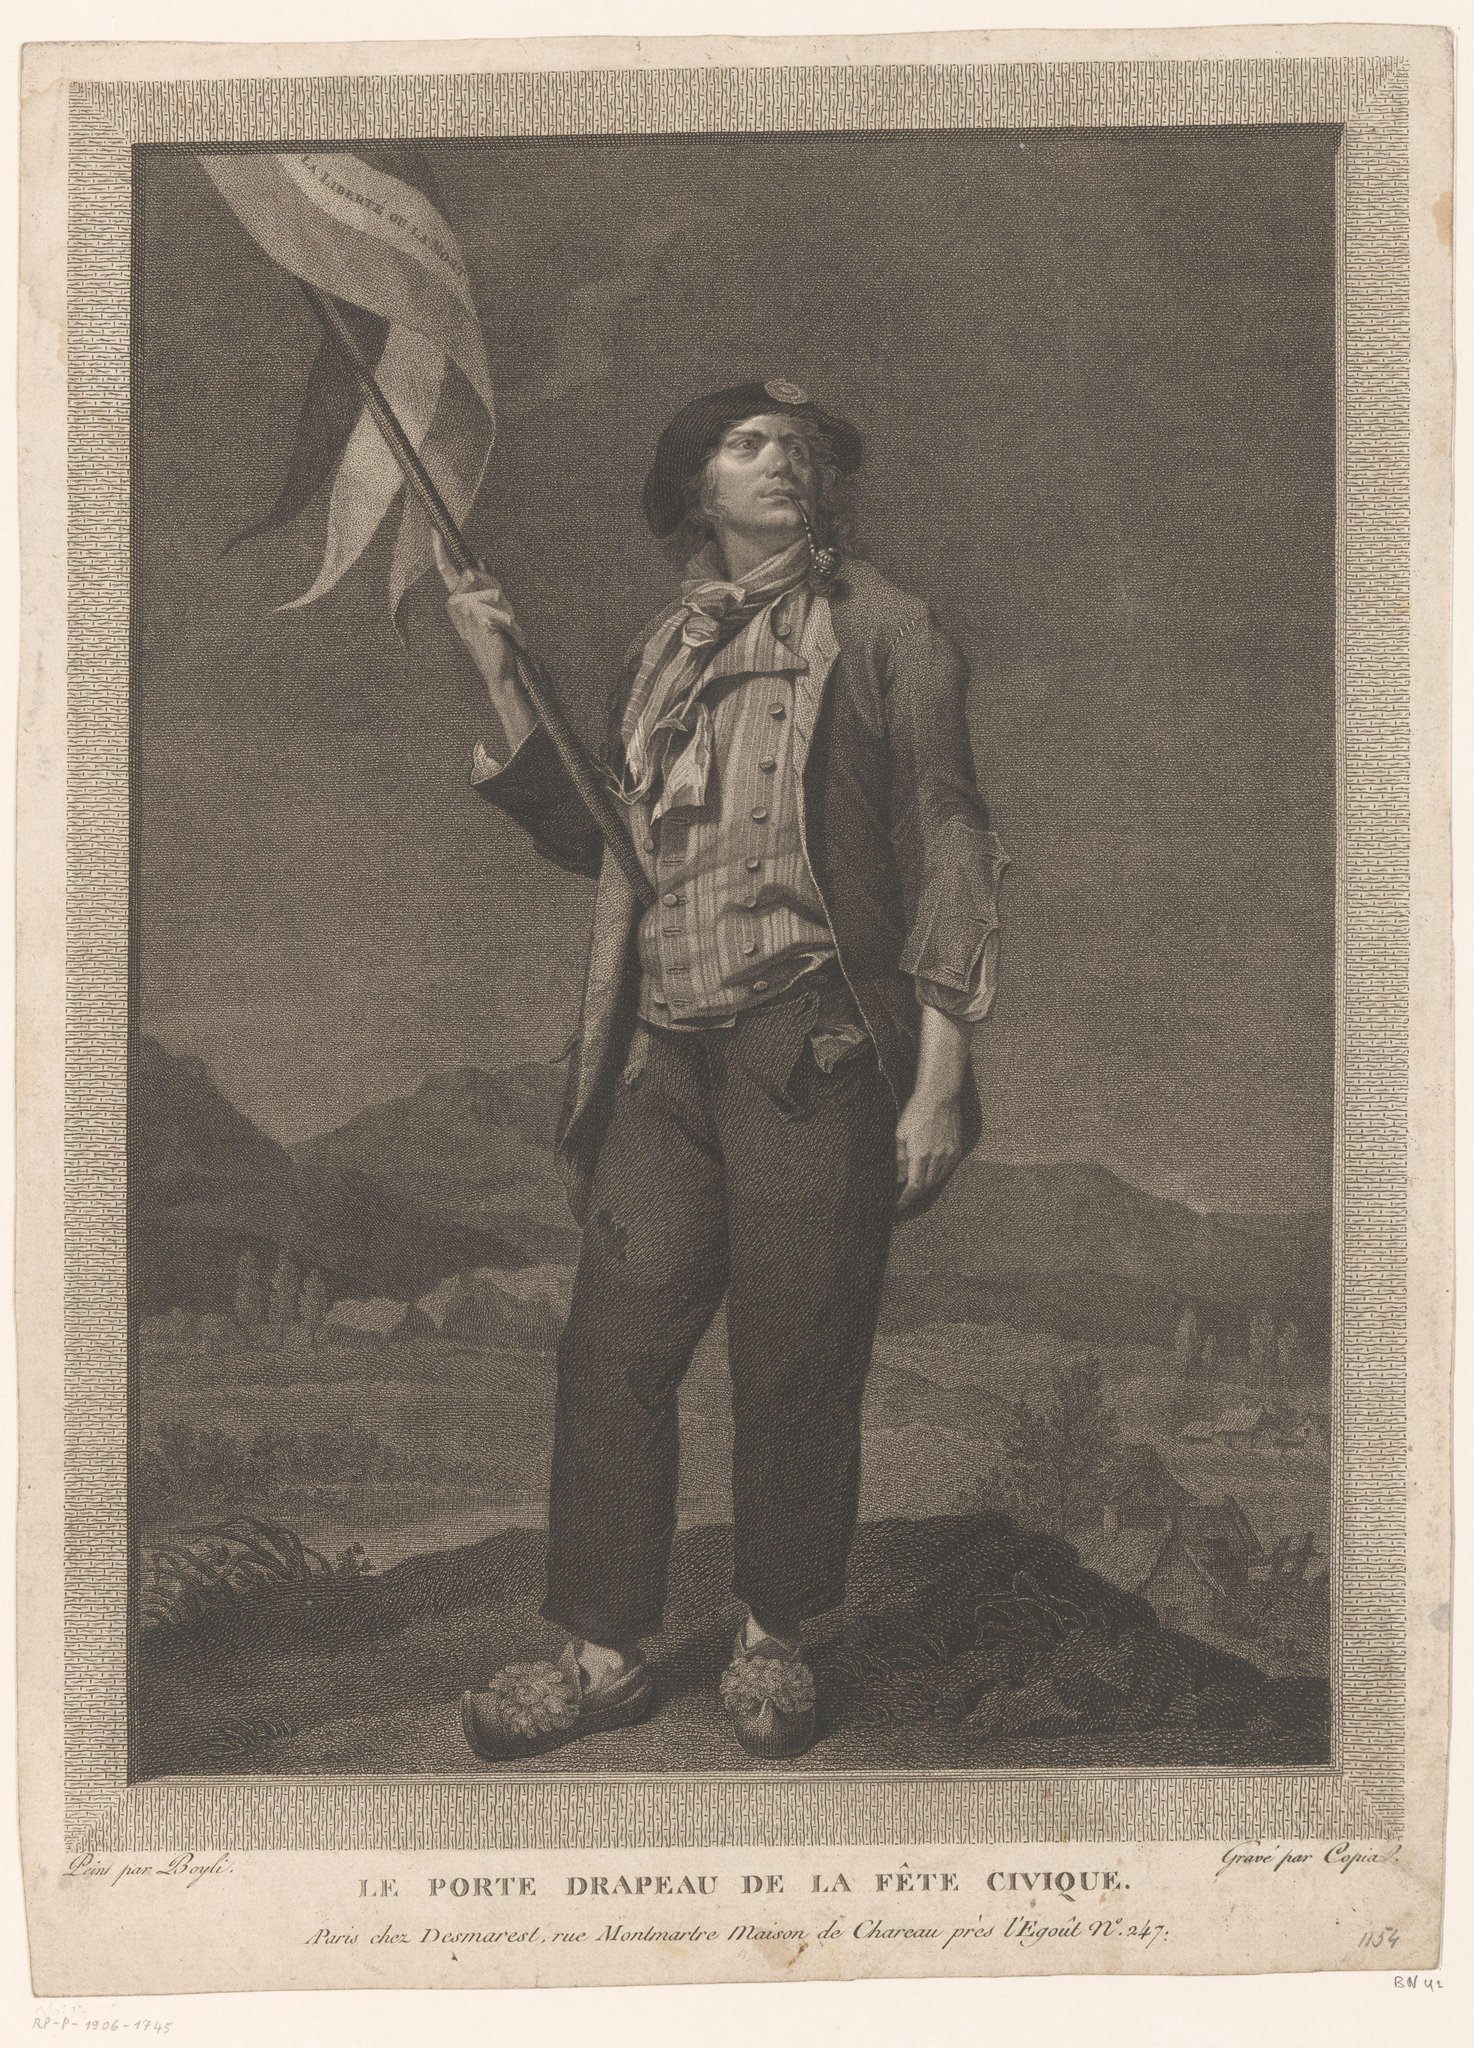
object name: print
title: Vlagdrager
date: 1789-1799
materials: paper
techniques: etching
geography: france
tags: (military) standard-bearer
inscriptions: collector's mark: Lugt 2228